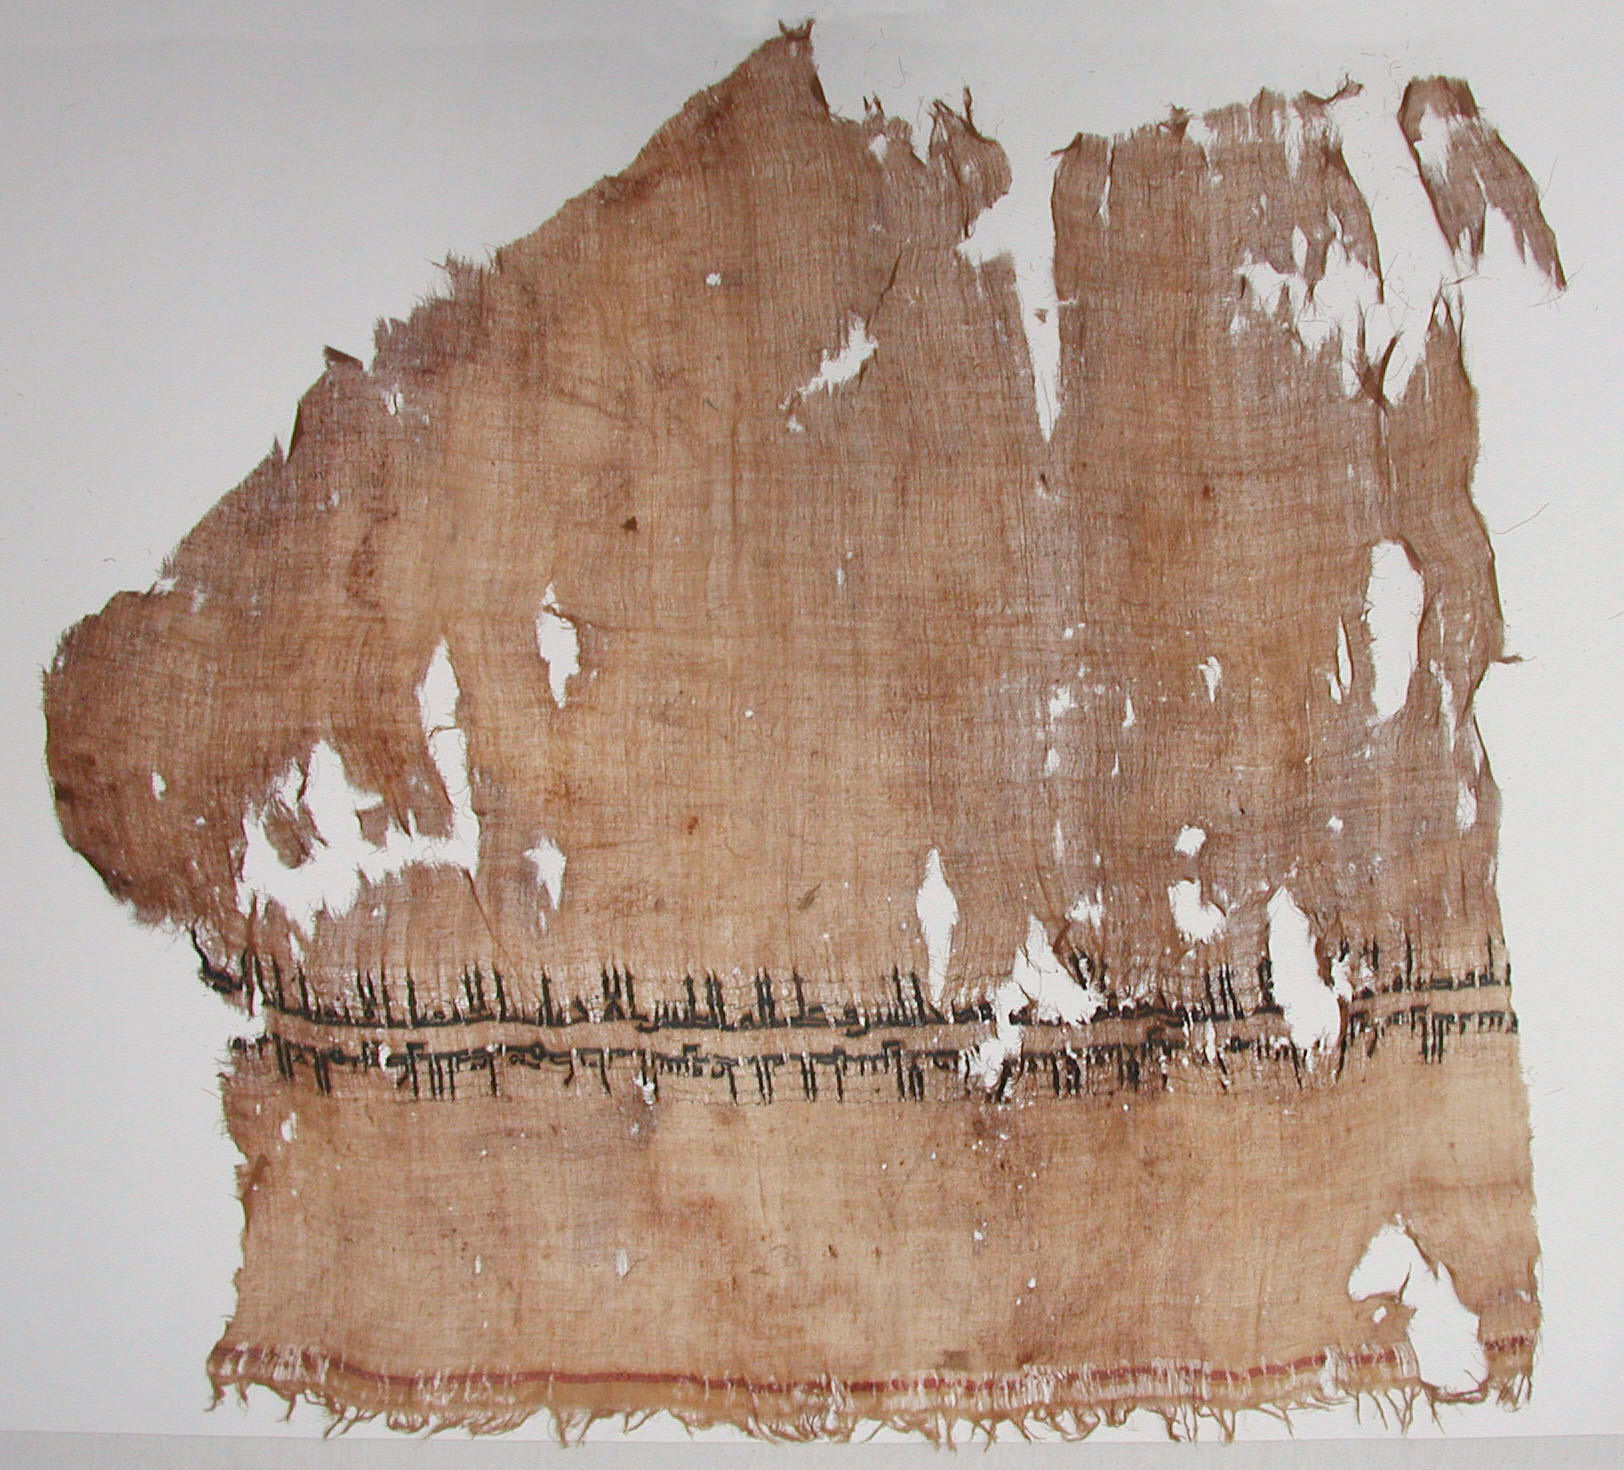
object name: textile fragment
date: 901-1000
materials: linen, silk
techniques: weave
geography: egypt